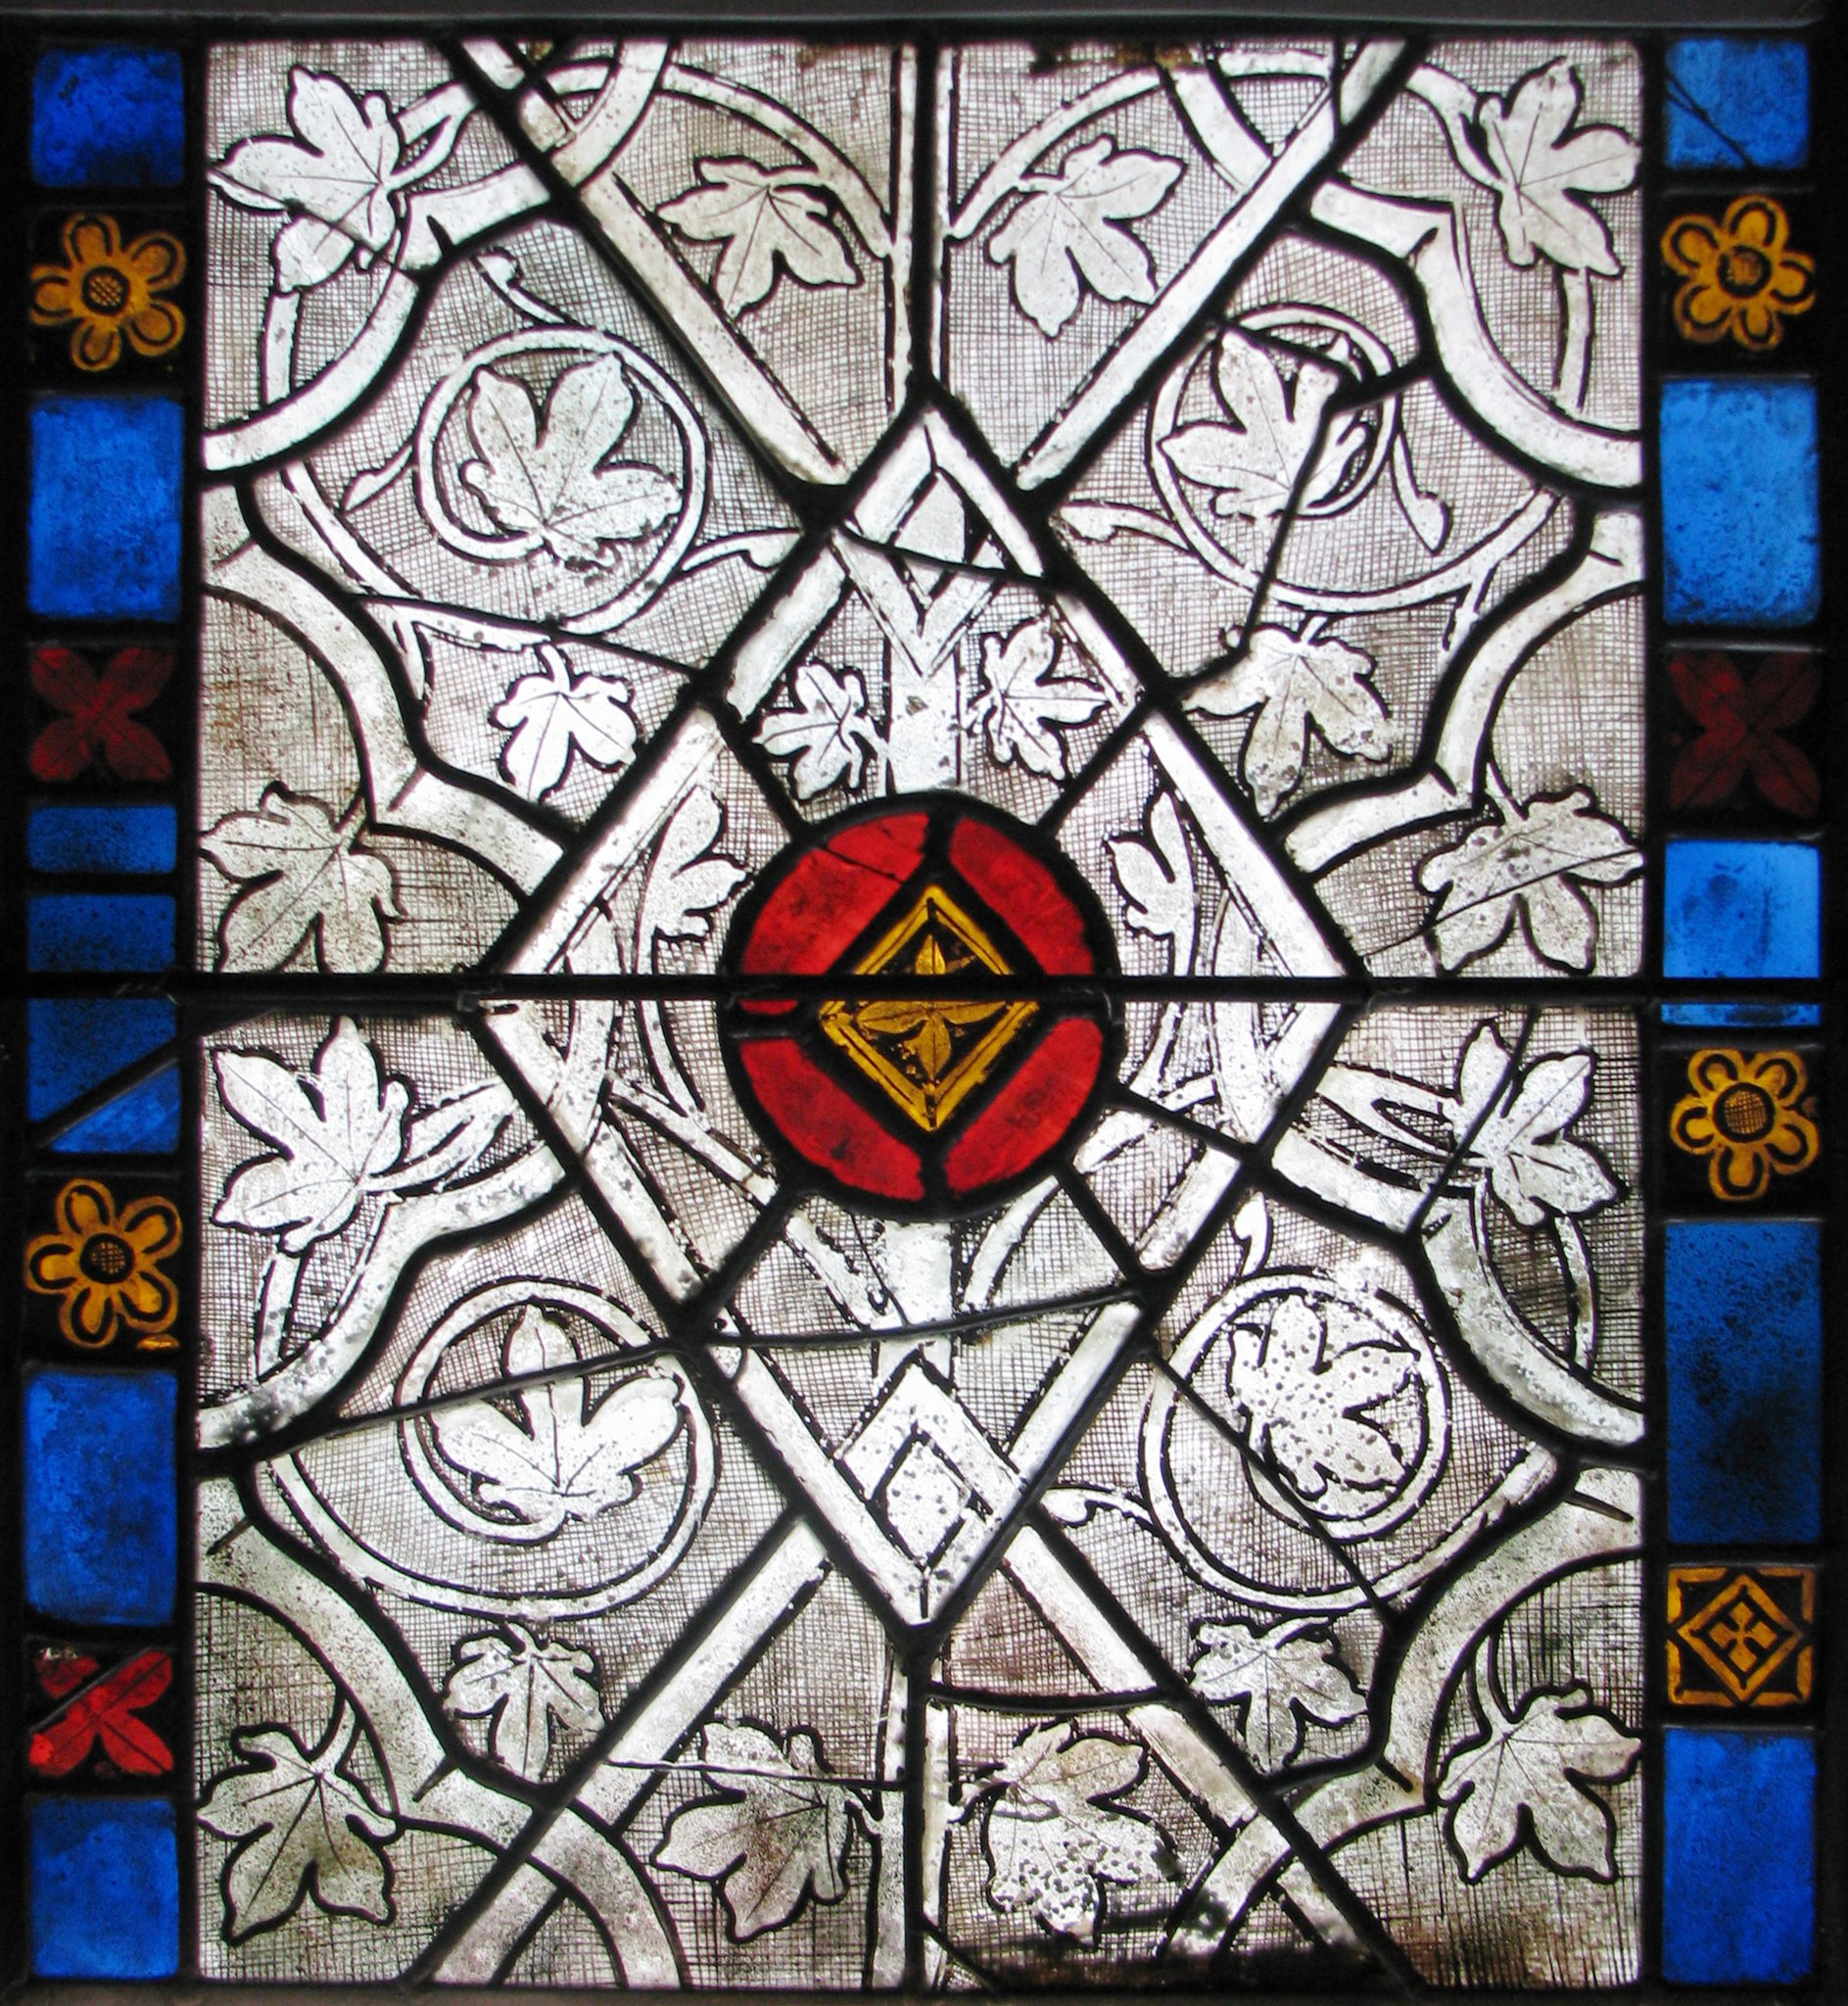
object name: panel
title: Grisaille Panel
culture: french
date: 1270-1280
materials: glass, metal, paint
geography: france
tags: leaves